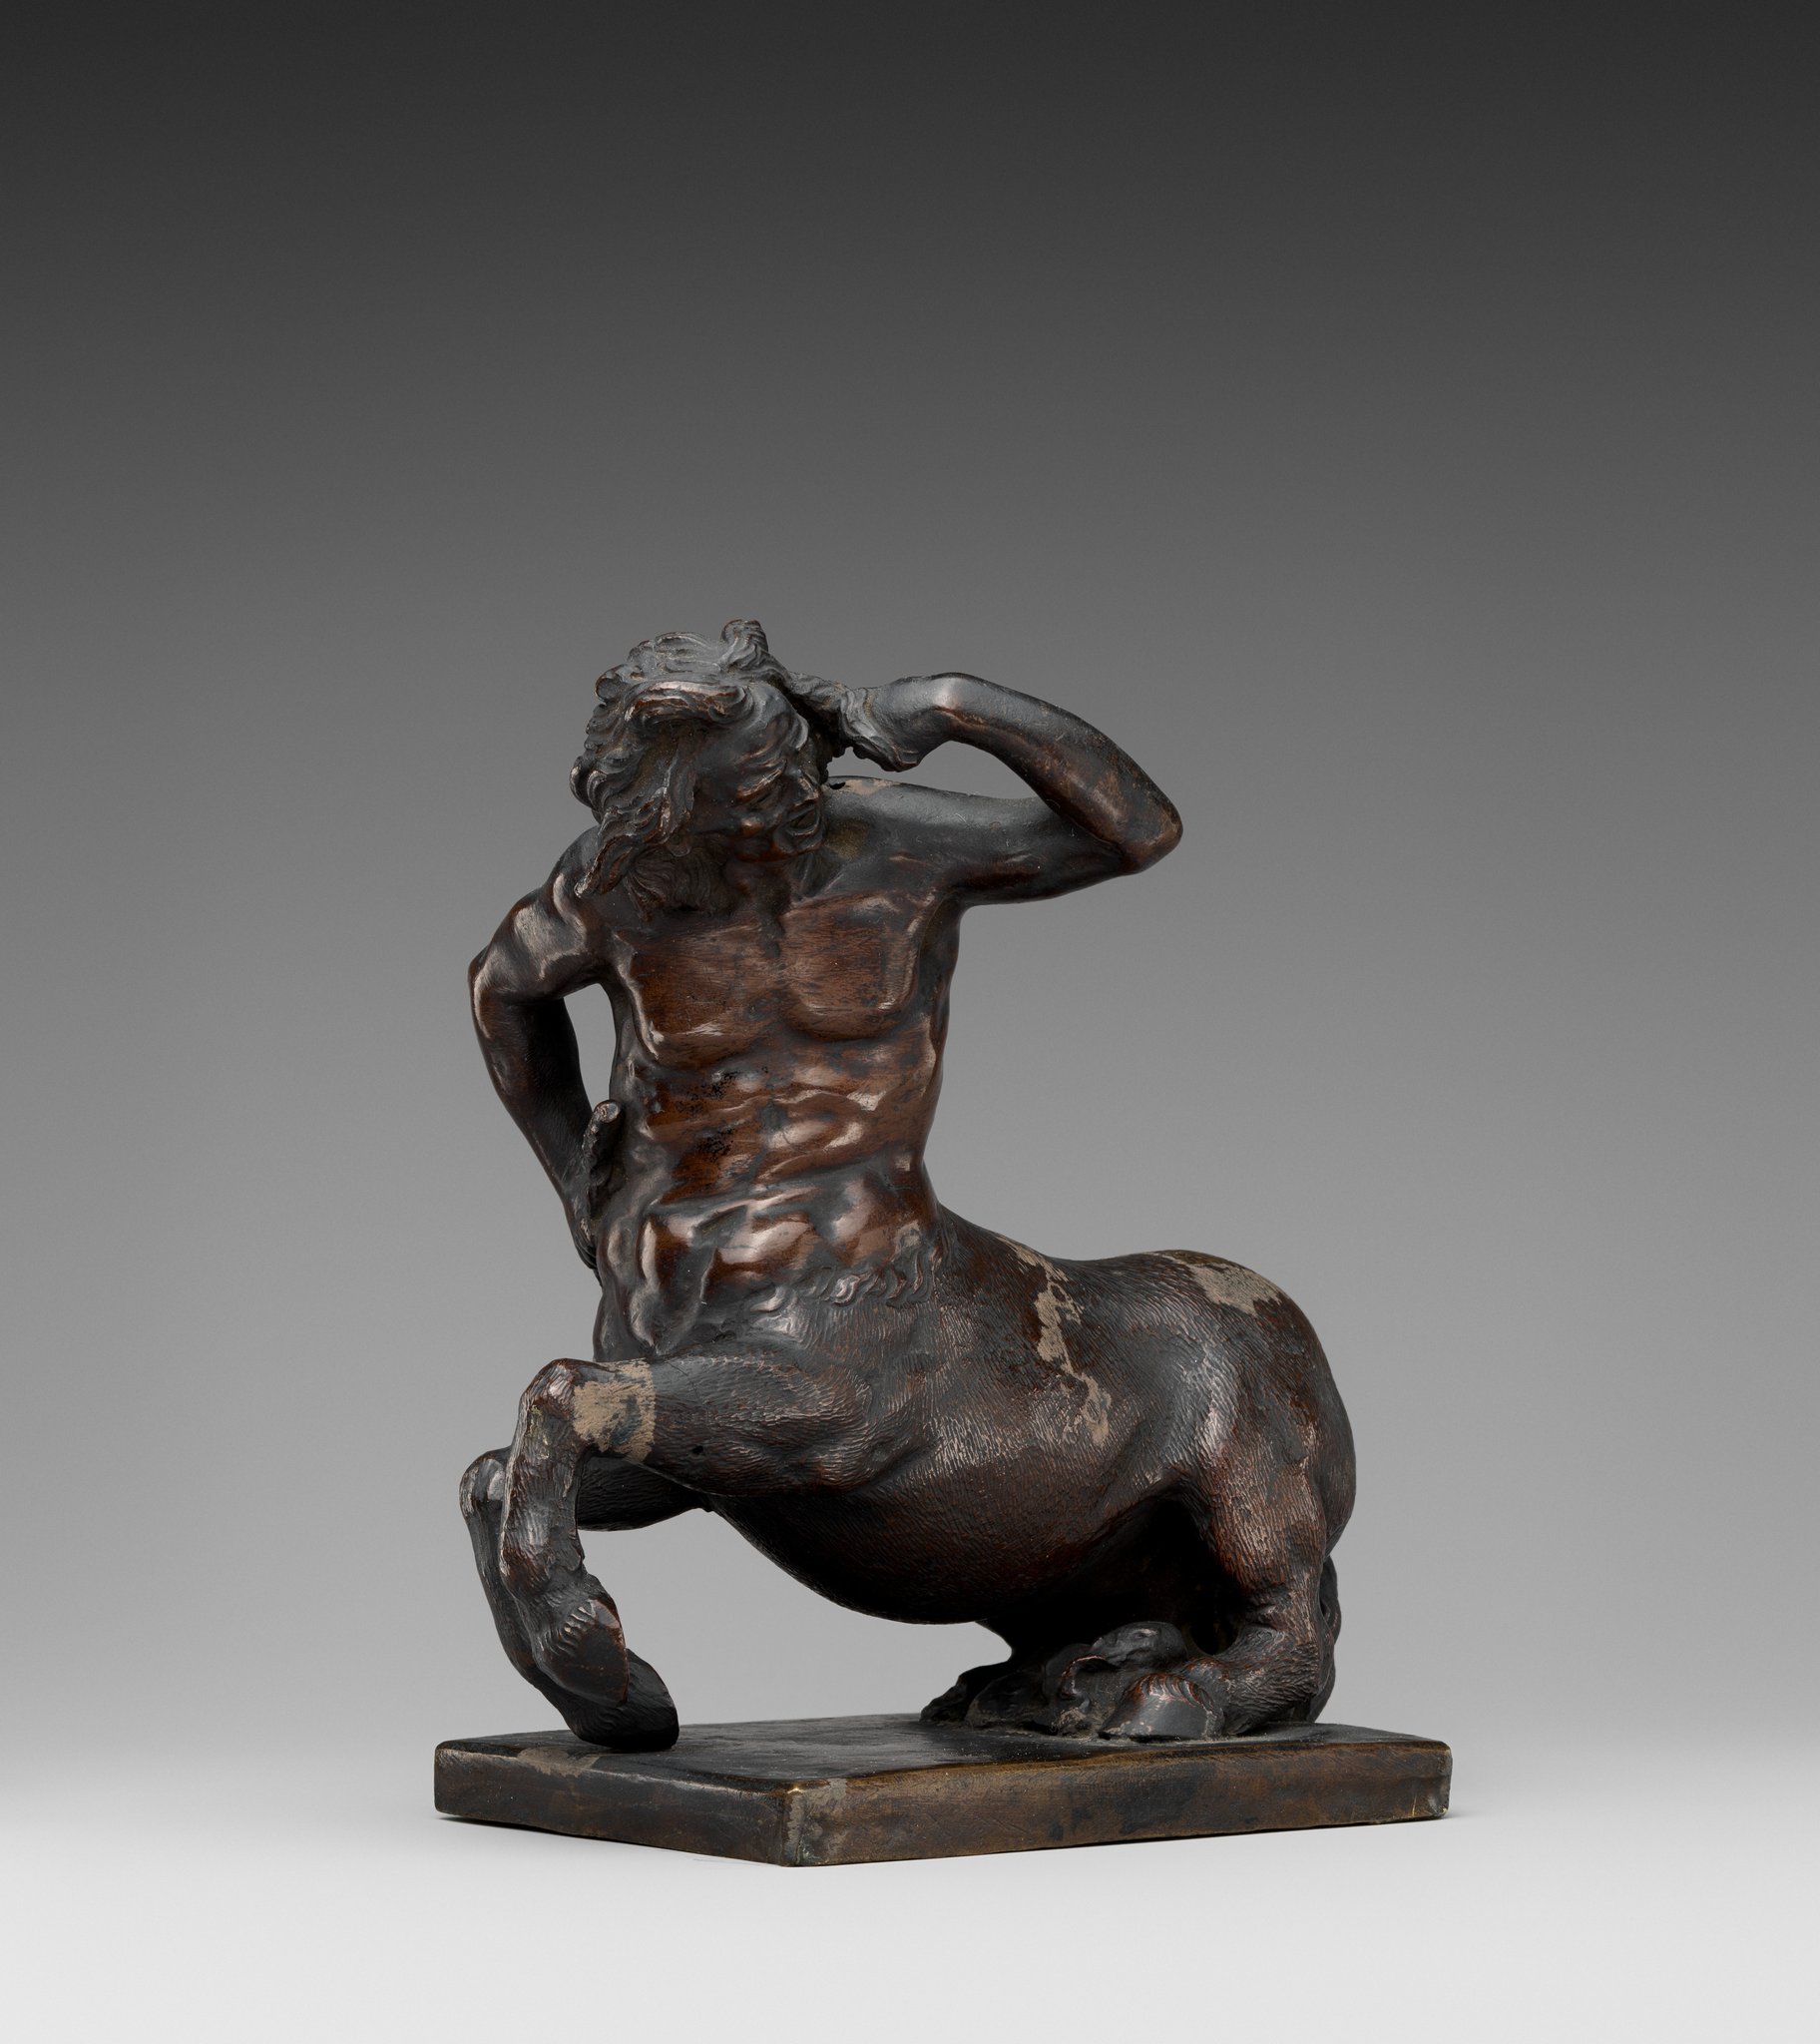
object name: statuette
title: Centaur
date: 1601-1700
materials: bronze, marble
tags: centaurs